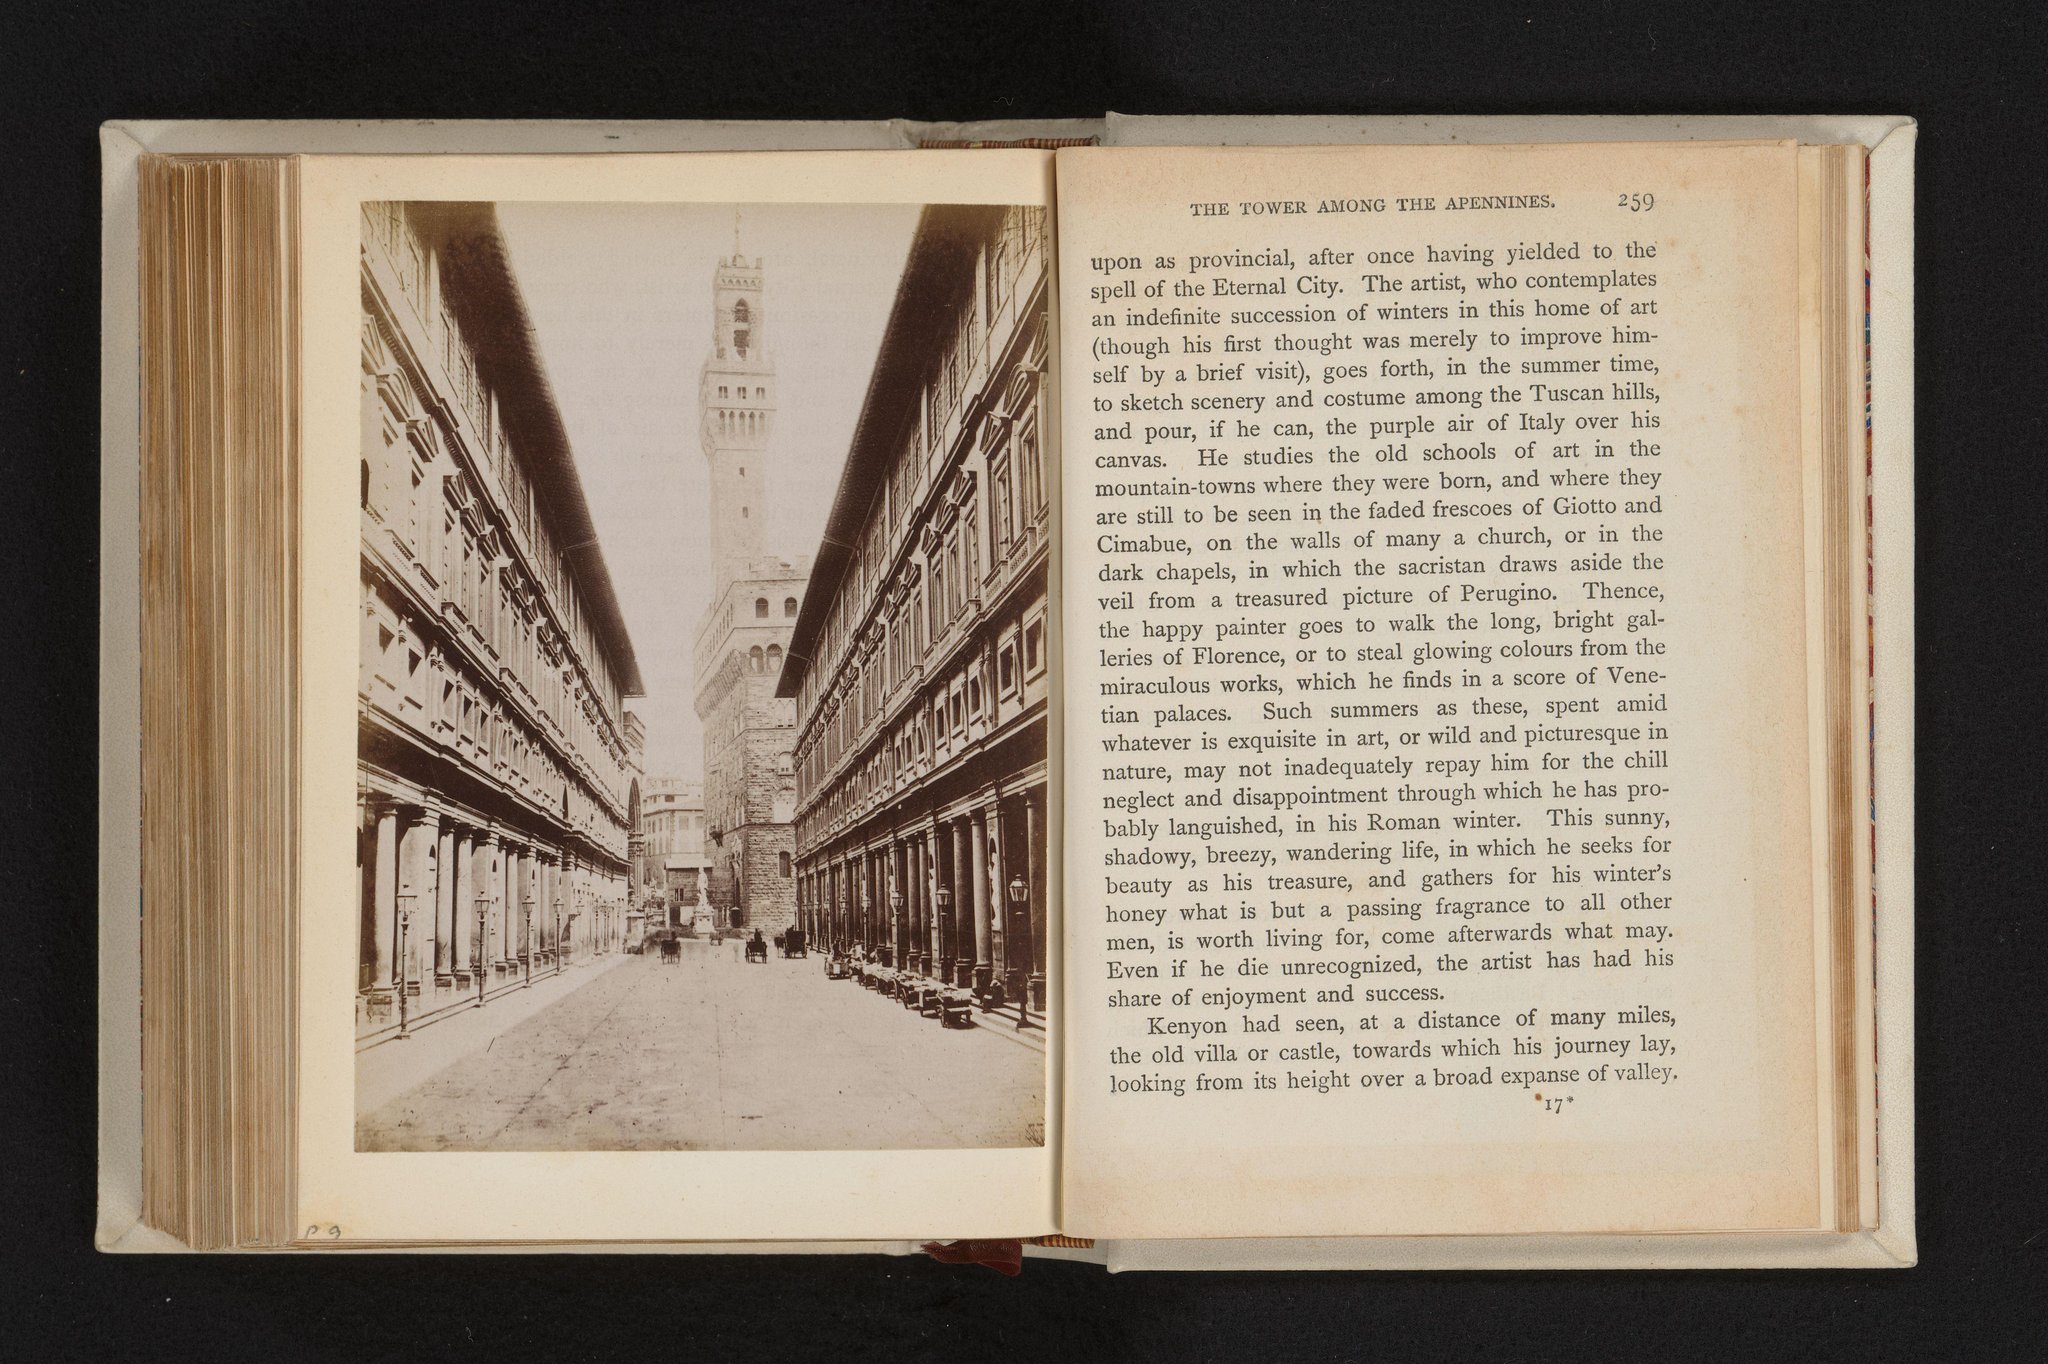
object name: page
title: Gezicht op Palazzo Vecchio en de Galleria degli Uffizi in Florence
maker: Anonymous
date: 1850-1860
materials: photographic support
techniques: albumen print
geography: florence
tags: tower, clock tower ~ monumental adornment, permanent exhibition, museum